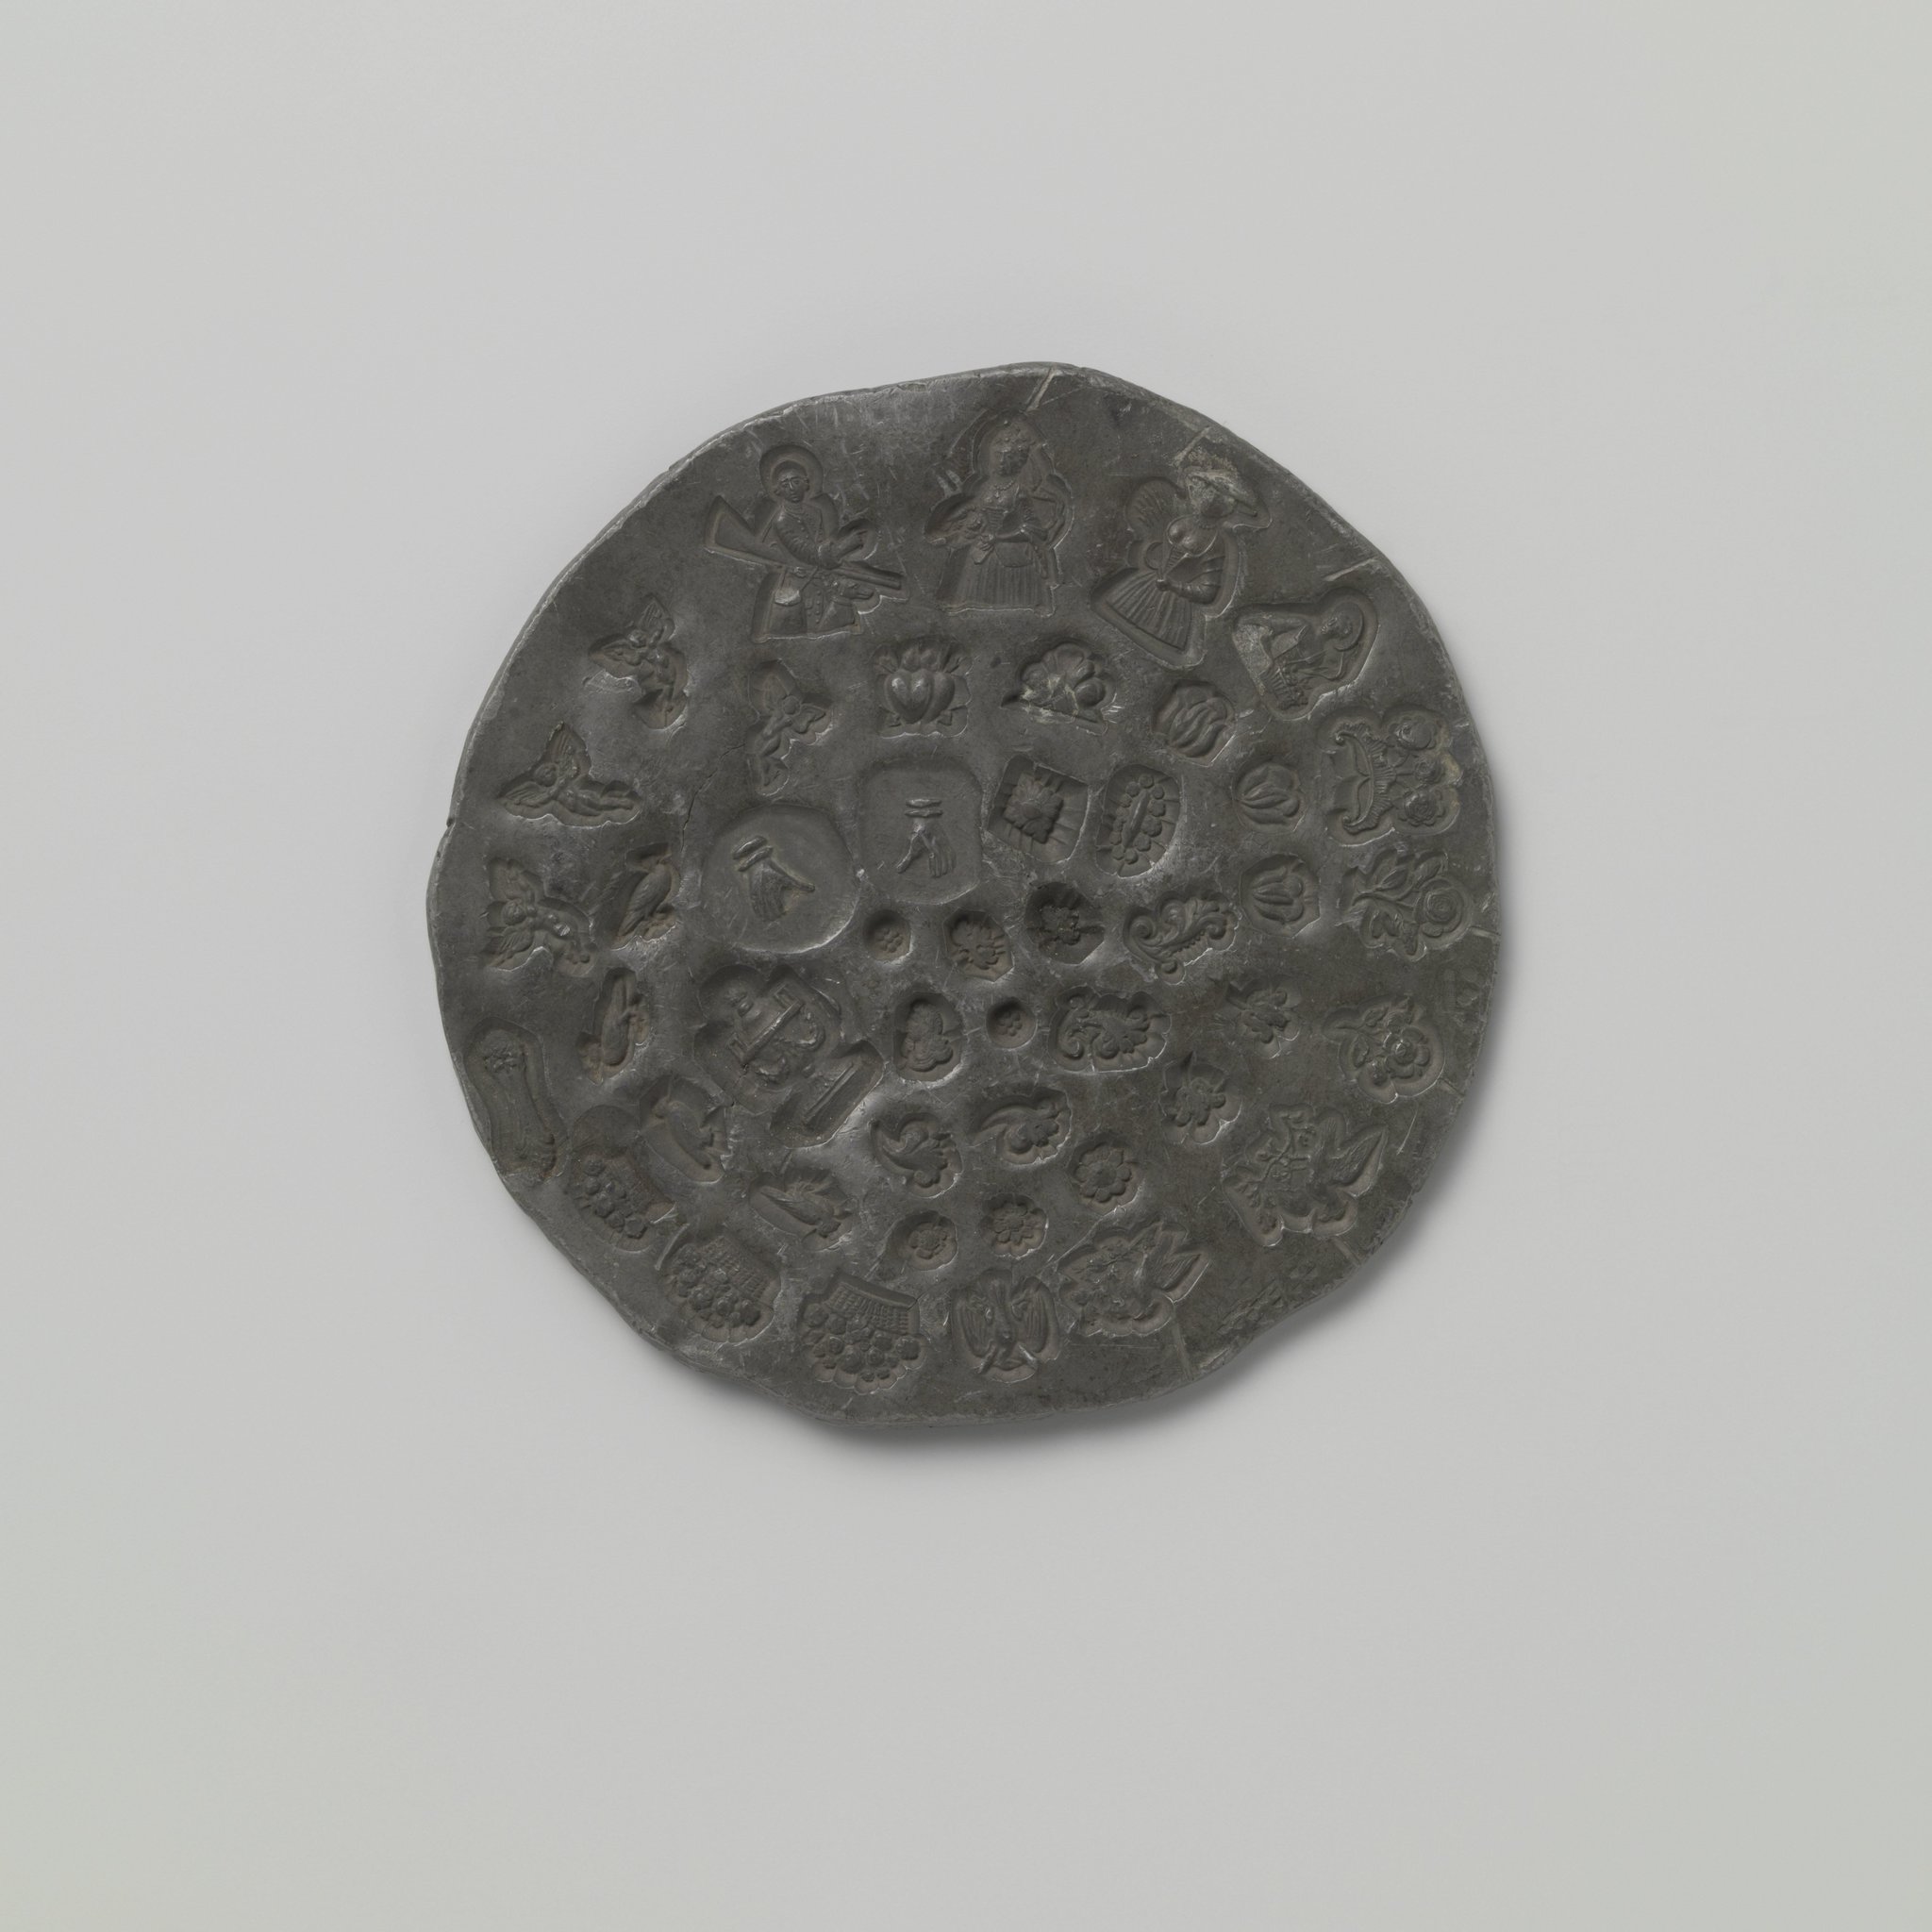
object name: plate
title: Plaat van tin met afdrukken van ornamenten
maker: Anonymous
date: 1750-1800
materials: tin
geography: northern netherlands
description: Ronde plaat van tin met afslagen ornamenten voor tinnen objecten.